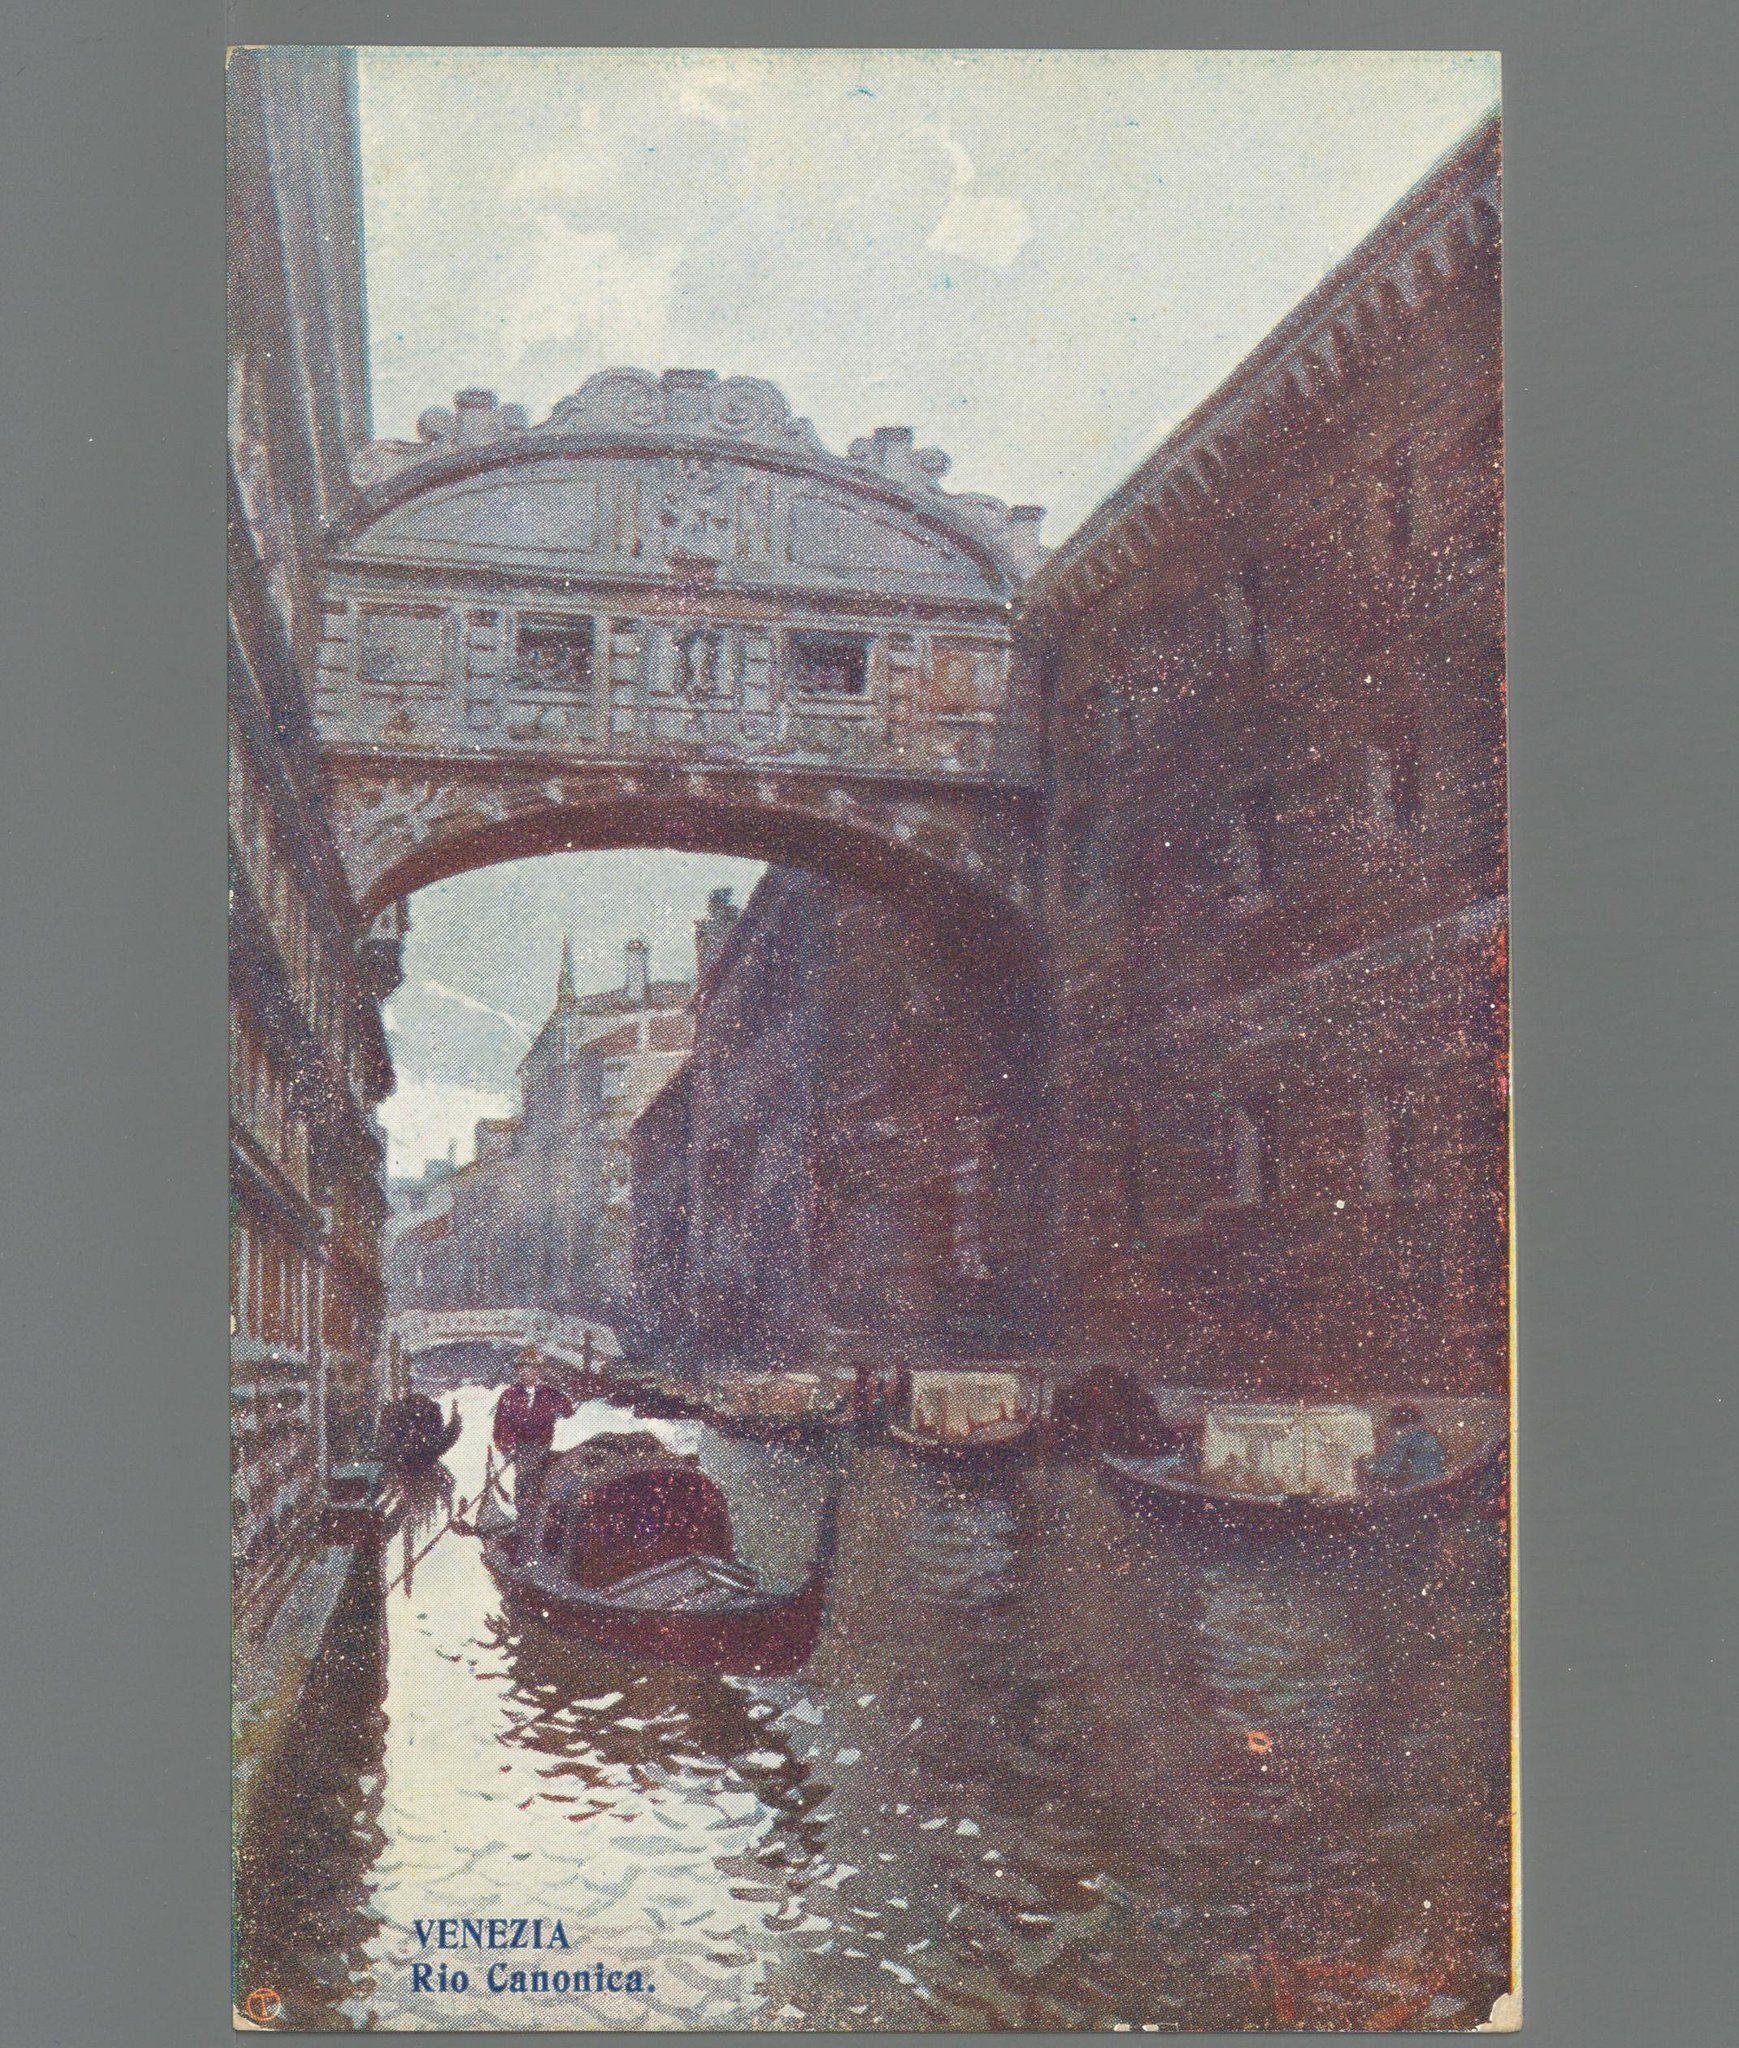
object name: ansichtkaart, prentbriefkaart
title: Venezia. Rio Canonica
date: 1906-1930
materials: cardboard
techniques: three-color autotype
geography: milan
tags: river, gondola, city-view, and landscape with man-made constructions (+ city(-scape) with figures, staffage), venice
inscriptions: signature